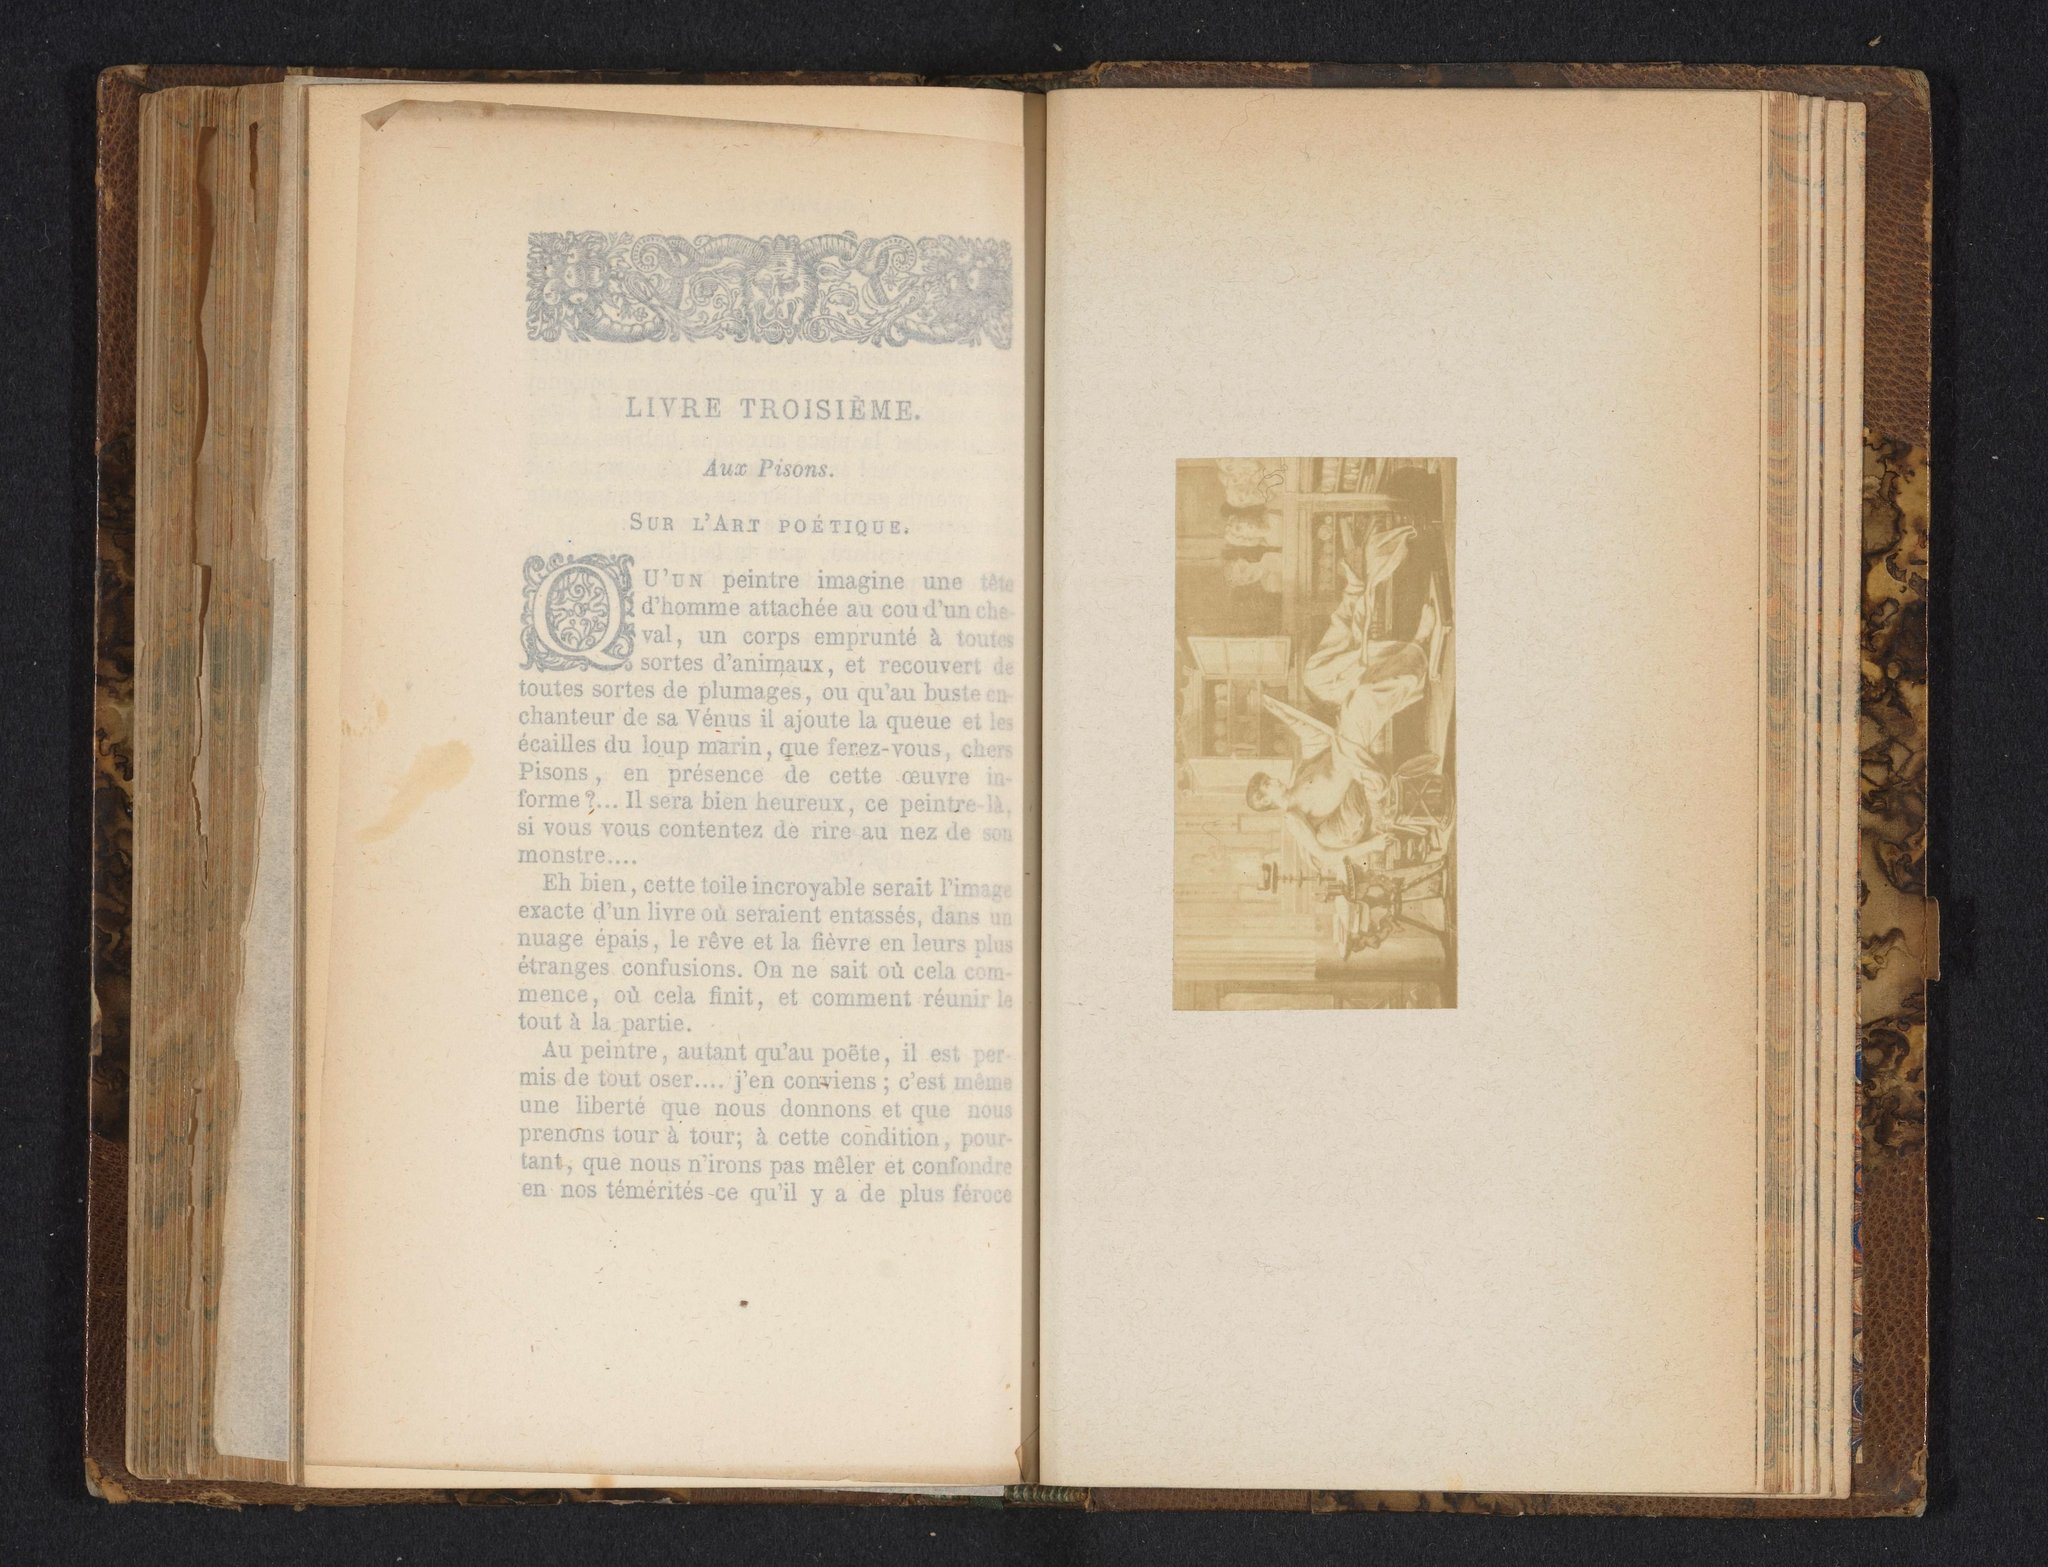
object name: reproduction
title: Fotoreproductie van een schilderij, voorstellende een halfnaakte man op een bank in een interieur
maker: Anonymous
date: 1851-1861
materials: photographic support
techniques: albumen print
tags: interior ~ representation of a building, lying figure, man (showing himself) undressed, quasi-nude